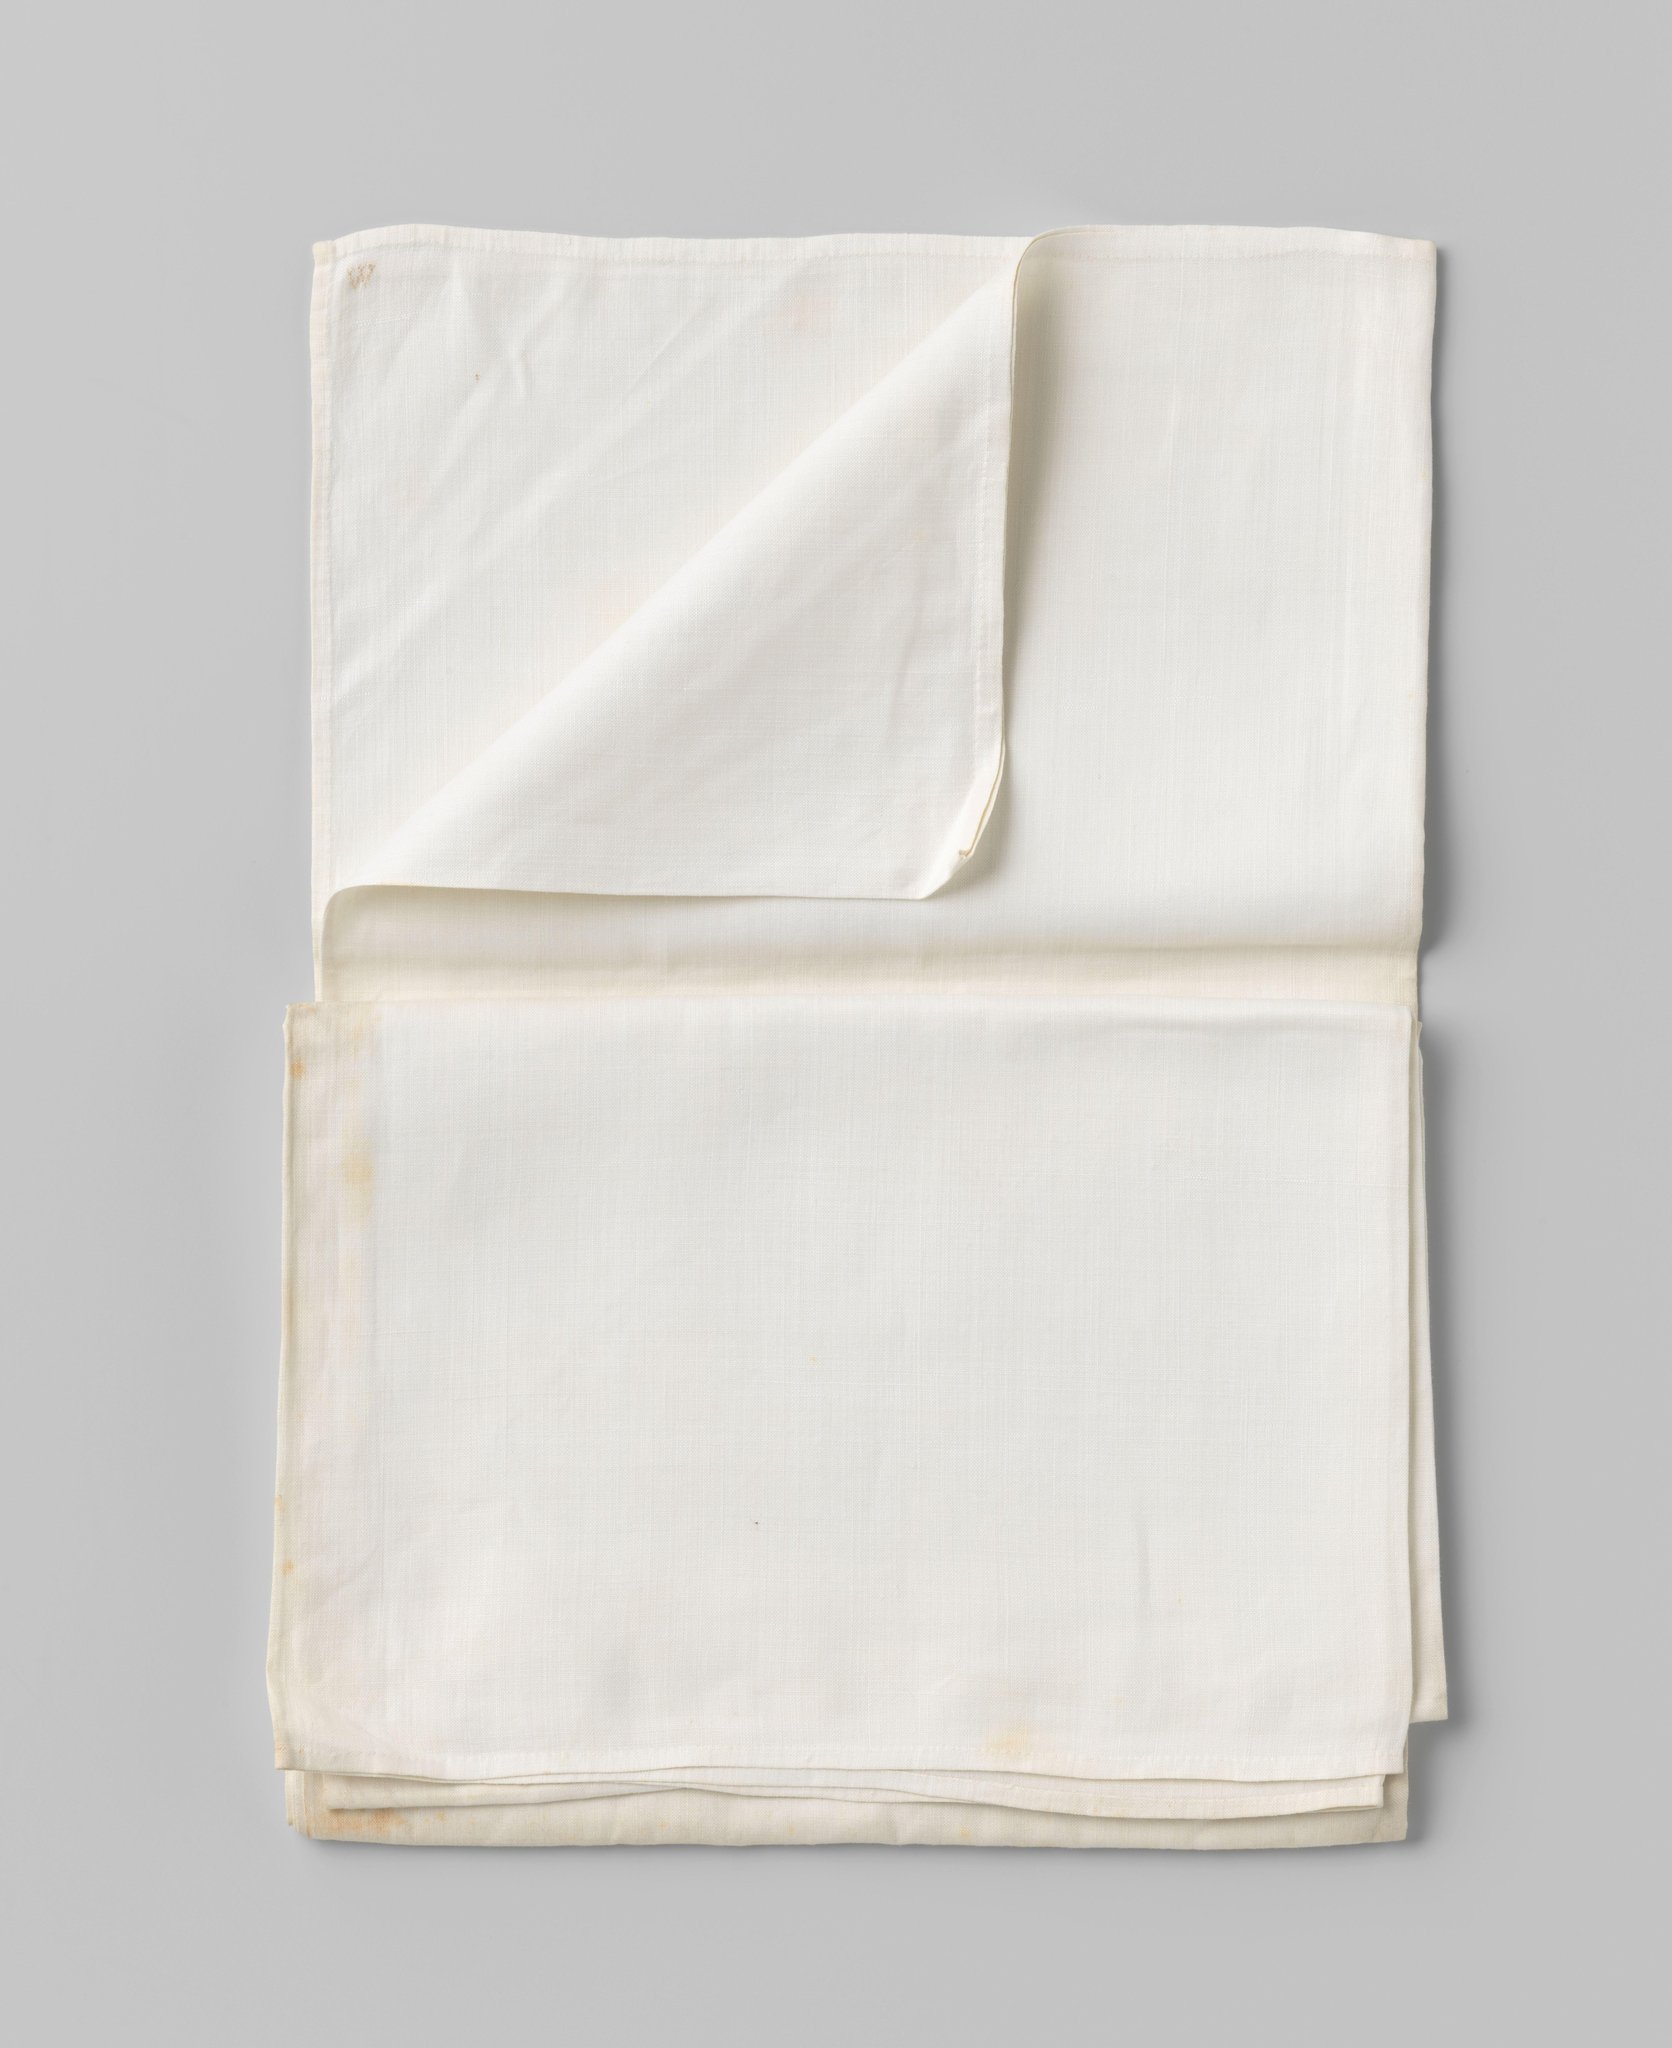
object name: beddenlaken, laken object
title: Laken. Merk: W.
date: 1791-1799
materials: linen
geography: northern netherlands